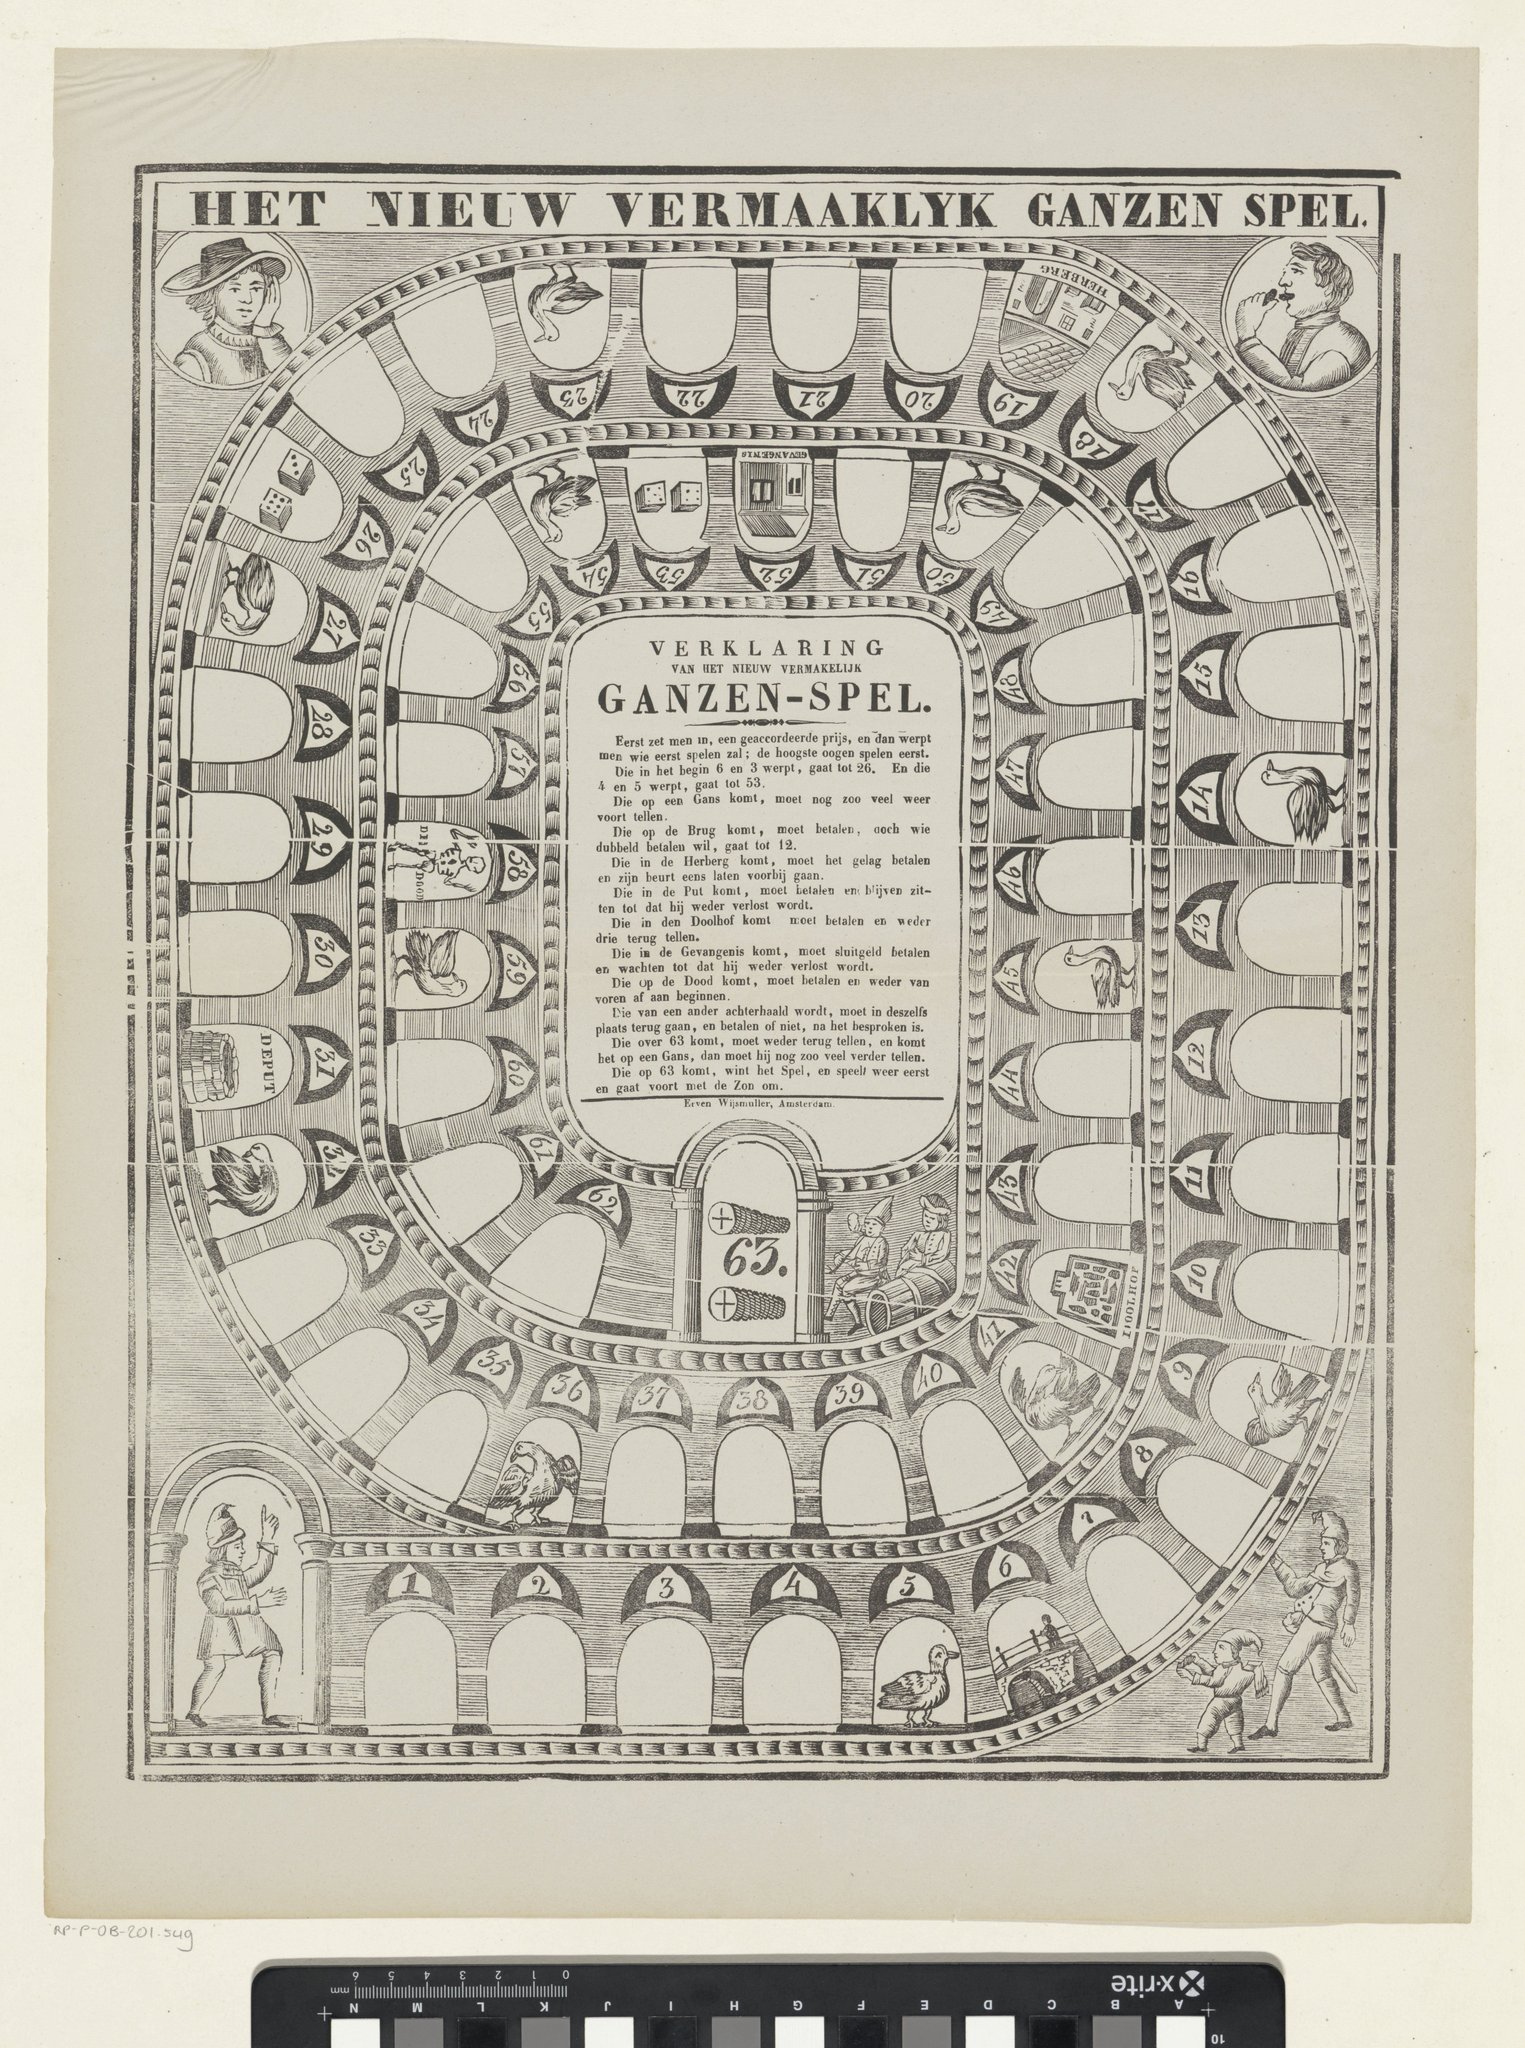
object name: gameboard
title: Het nieuw vermaaklyk ganzen spel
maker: Anonymous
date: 1800-1850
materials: paper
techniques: letterpress printing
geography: amsterdam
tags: goose-game, board-games of chance, board-games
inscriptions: collector's mark: Lugt 2760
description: Ganzenbordspel met spiraal met vakjes genummerd van 1 tot en met 63. In enkele vakjes voorstellingen van ganzen. In het grote centrale vak de spelregels in boekdruk. Titel in de bovenmarge.